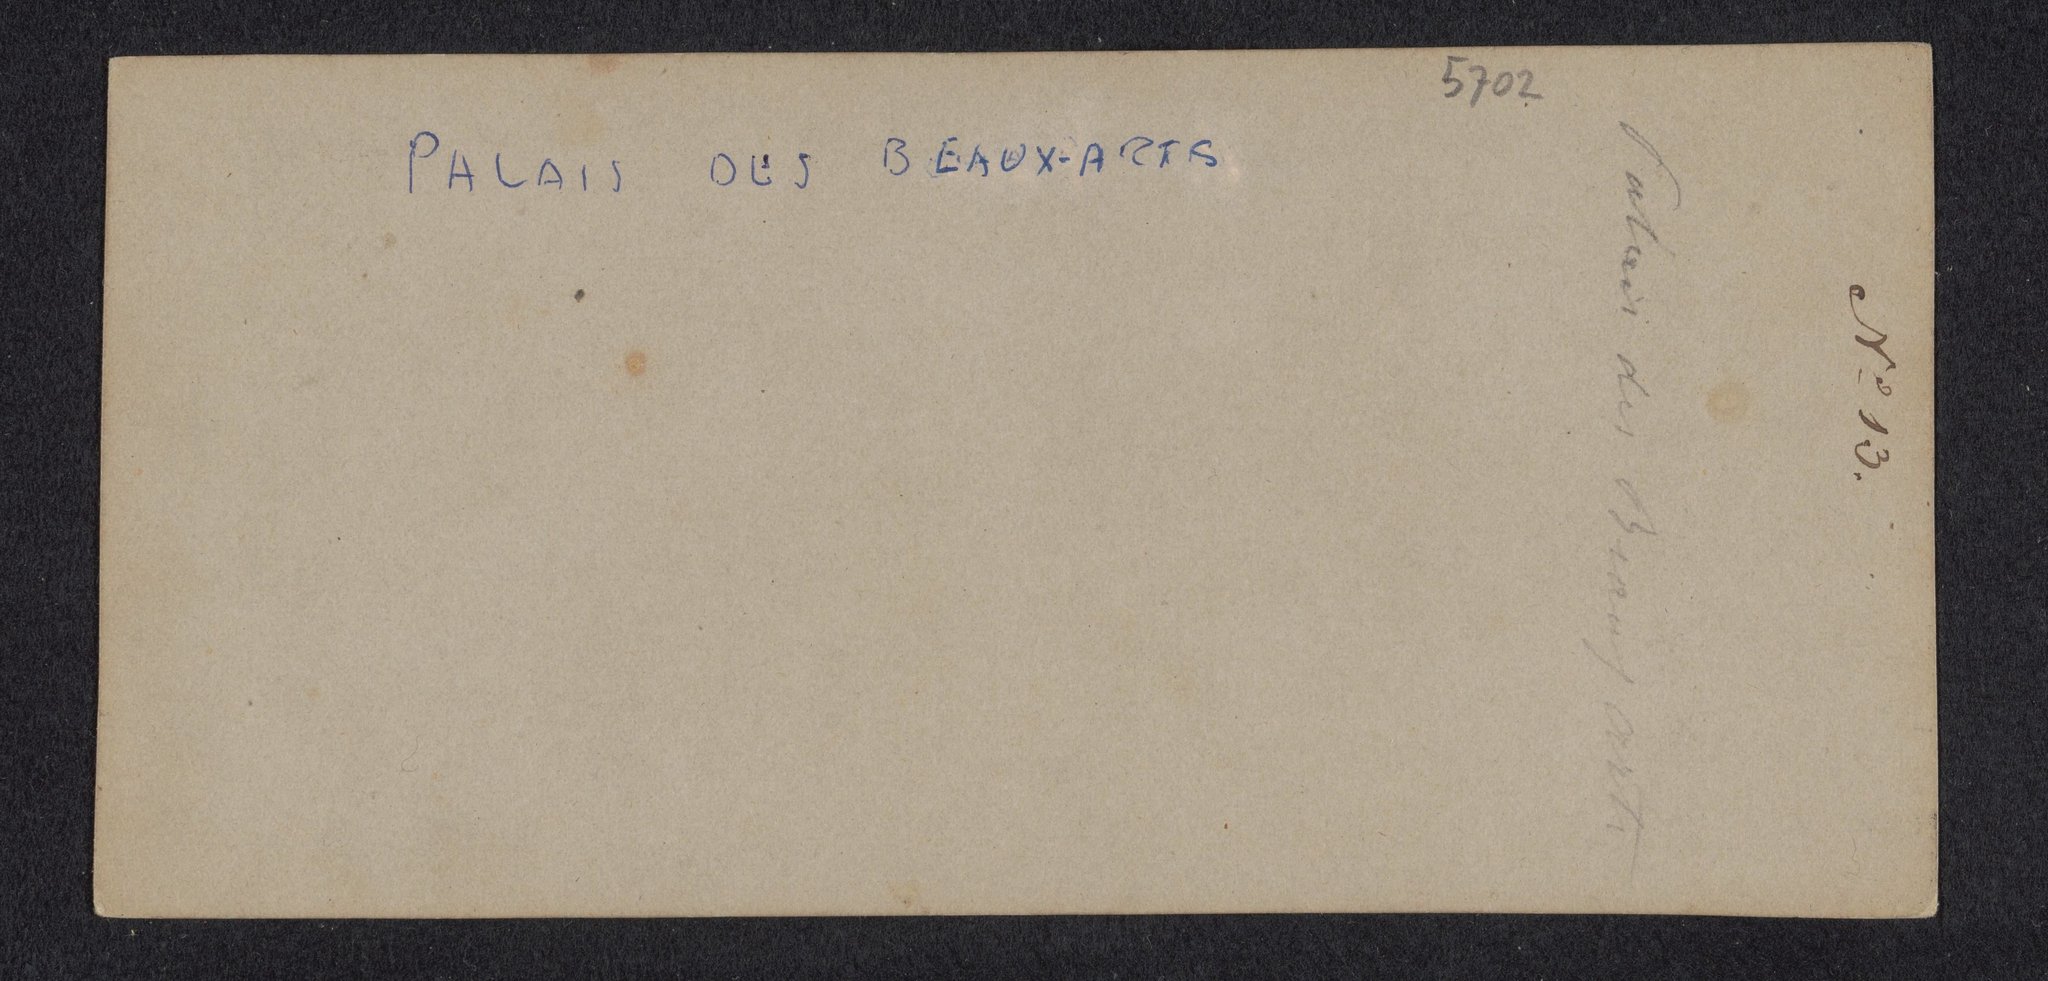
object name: stereograph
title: Gezicht op de École nationale supérieure des beaux-arts in Parijs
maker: Anonymous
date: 1855-1860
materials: cardboard, photographic support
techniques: albumen print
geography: paris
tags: place or institution of education and training of the artist, e.g.: academy of art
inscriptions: inscription: ‘Palais des Beaux Arts’, number: ‘No. 13.’